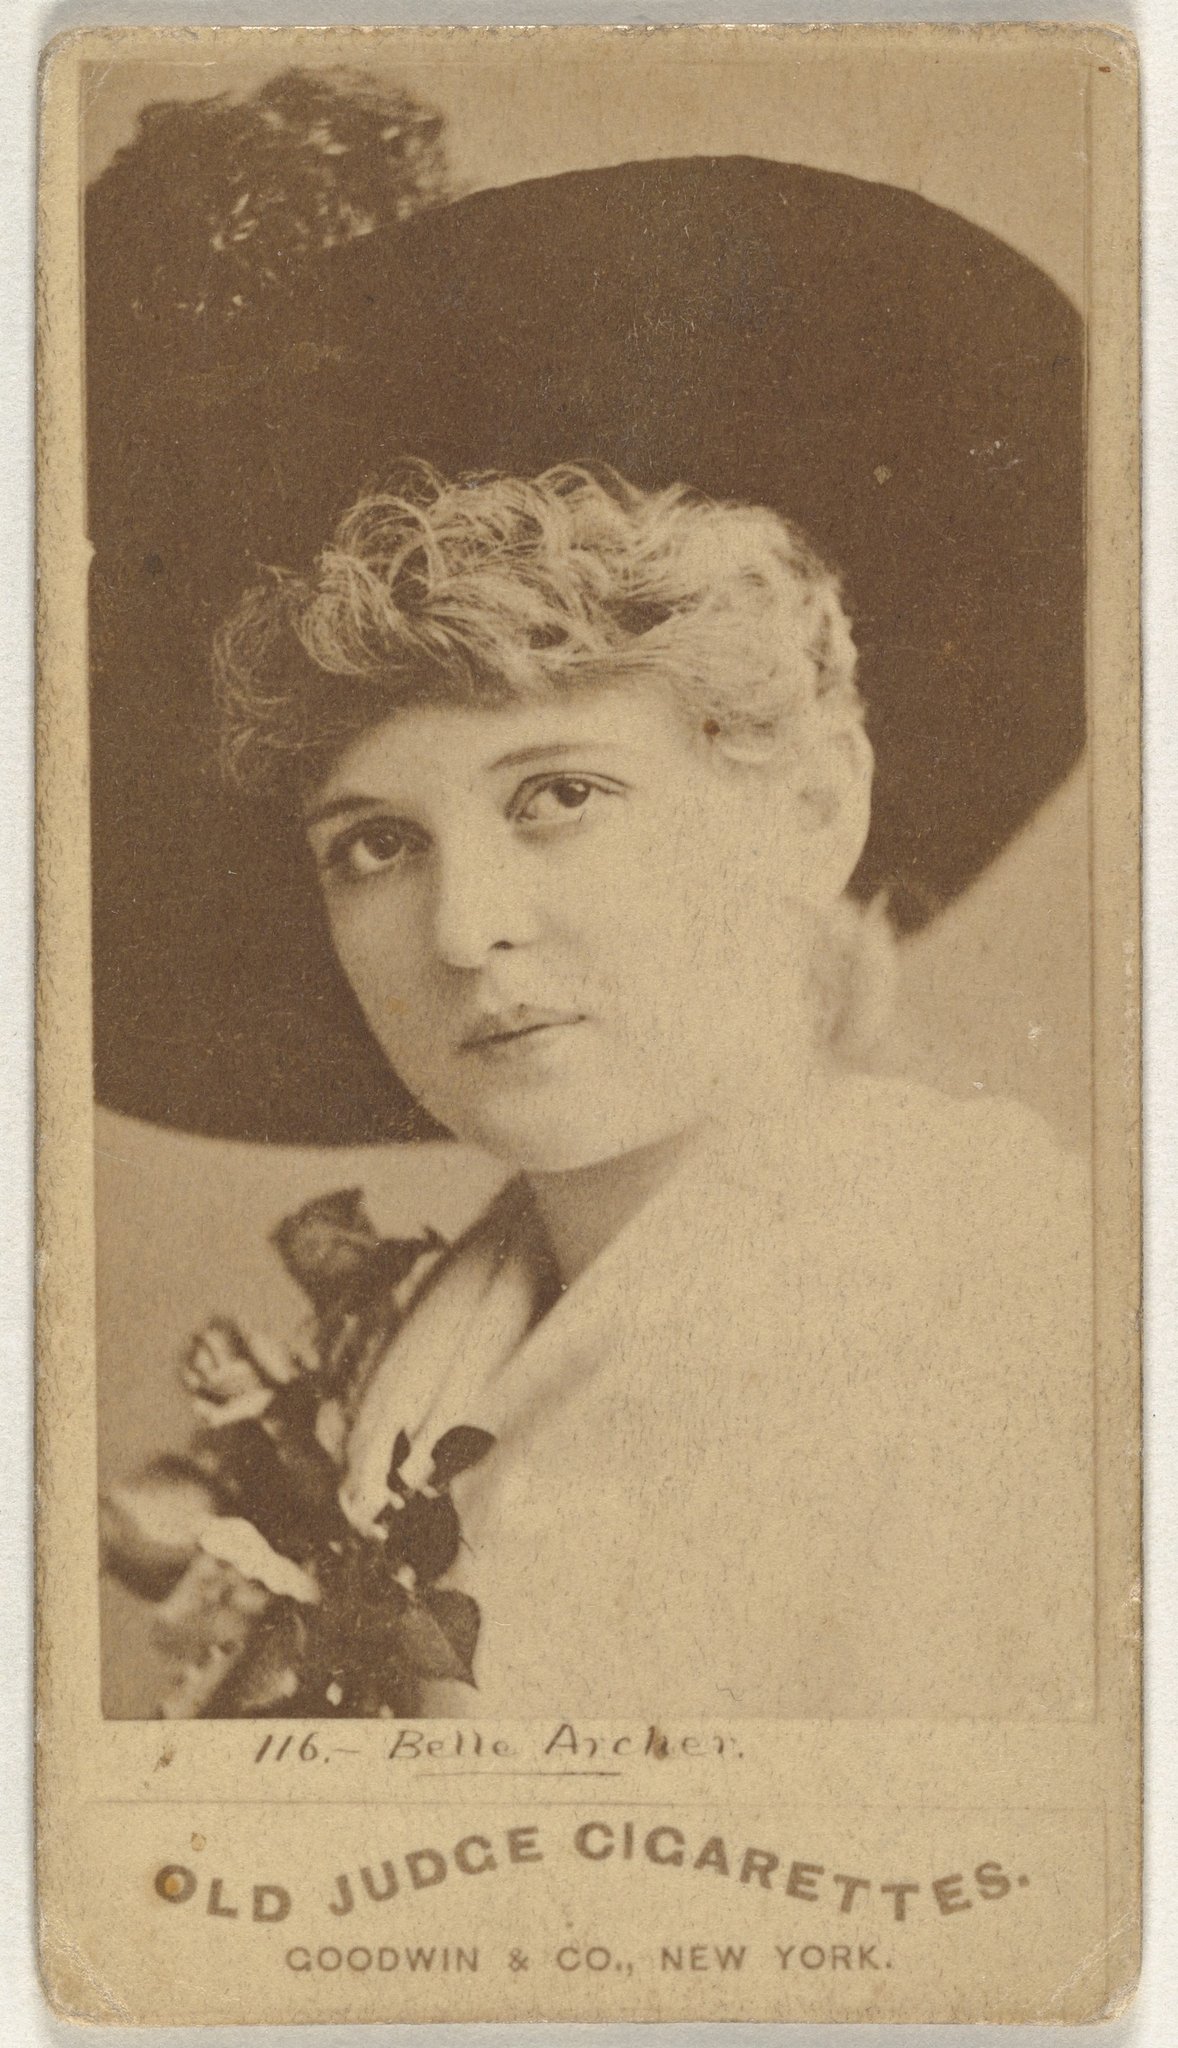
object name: photograph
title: Belle Archer, from the Actors and Actresses series (N171) for Old Judge Cigarettes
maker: goodwin & company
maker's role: publisher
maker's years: 1850-1950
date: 1886-1890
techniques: albumen silver print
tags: portraits,women,actresses